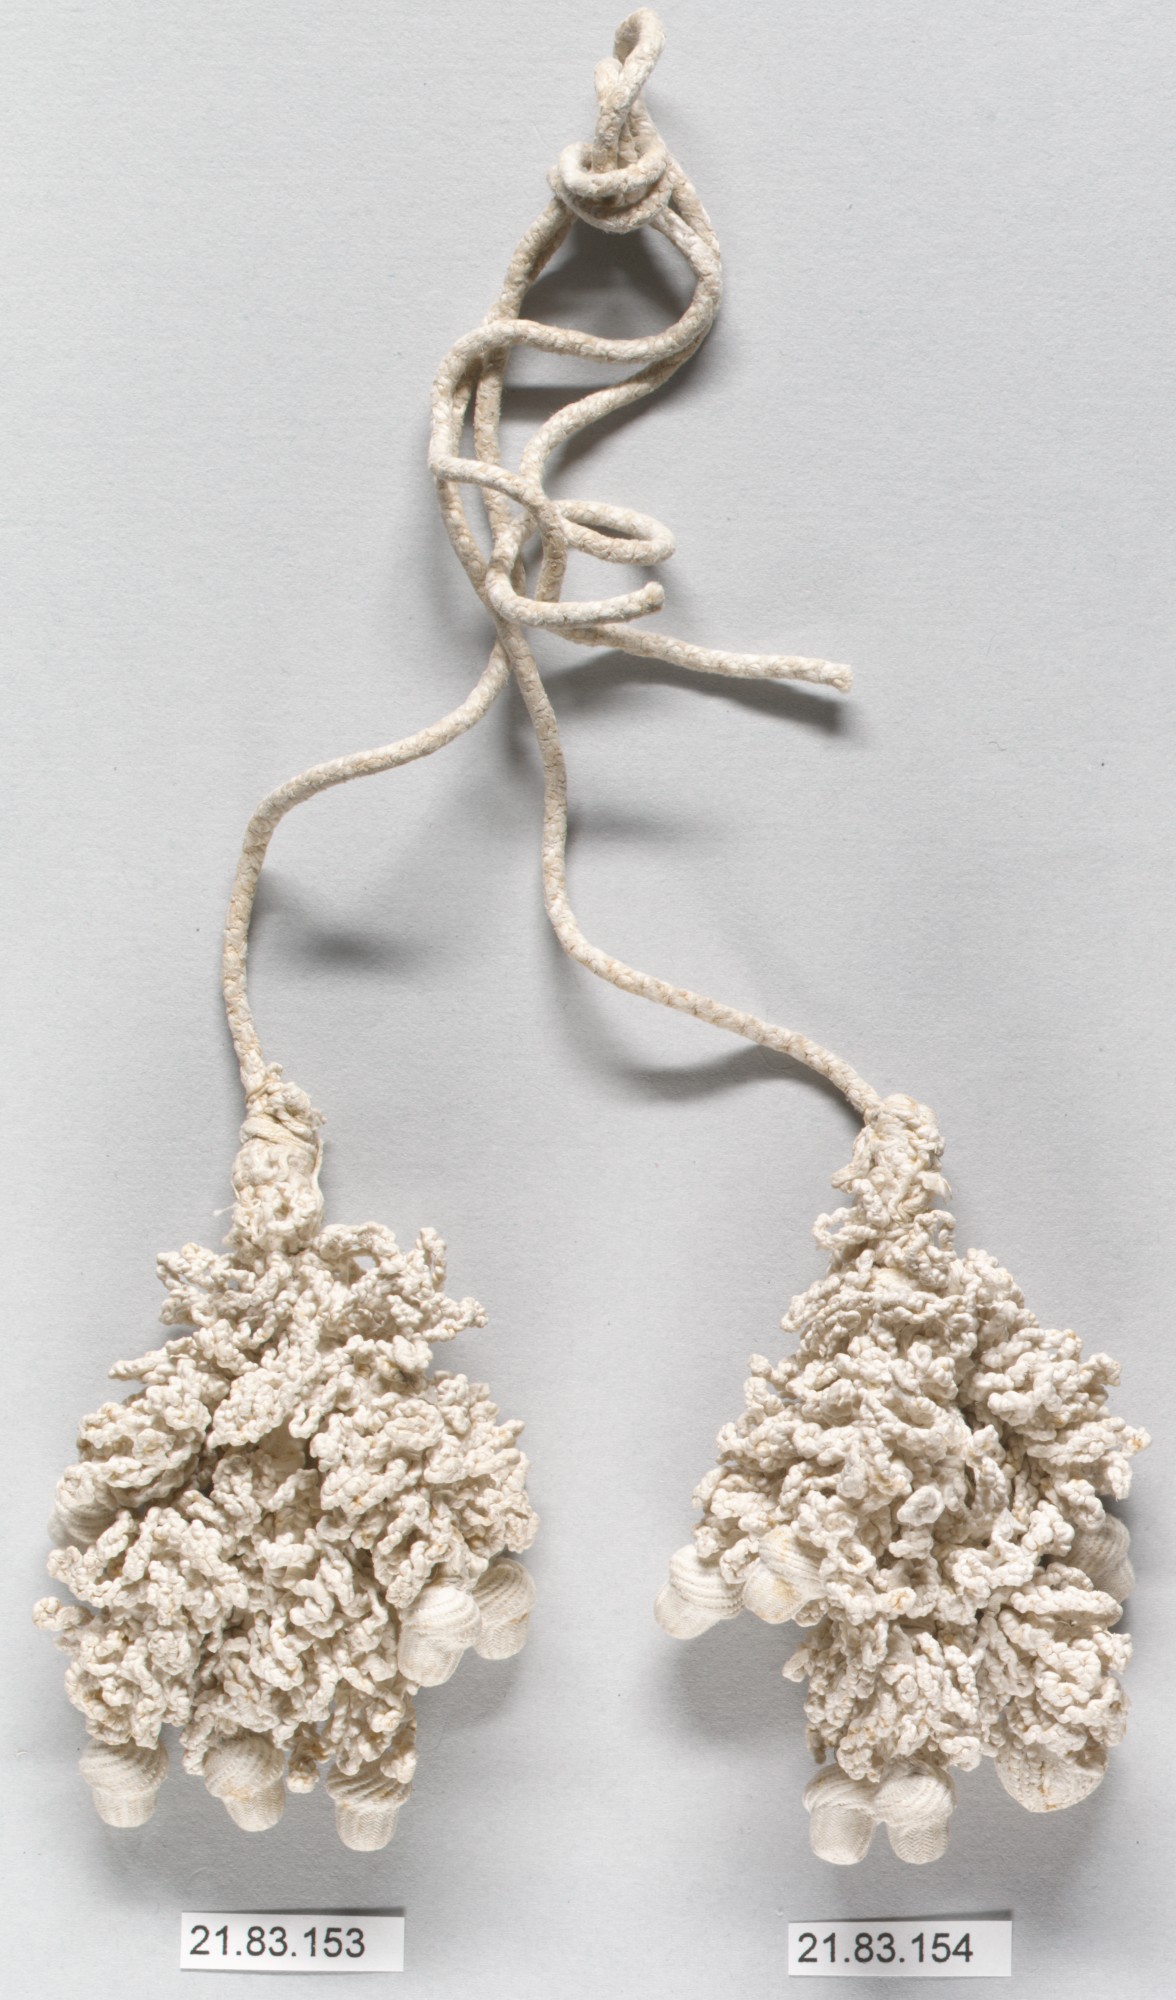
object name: tassel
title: Pair of tassels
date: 1601-1700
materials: linen